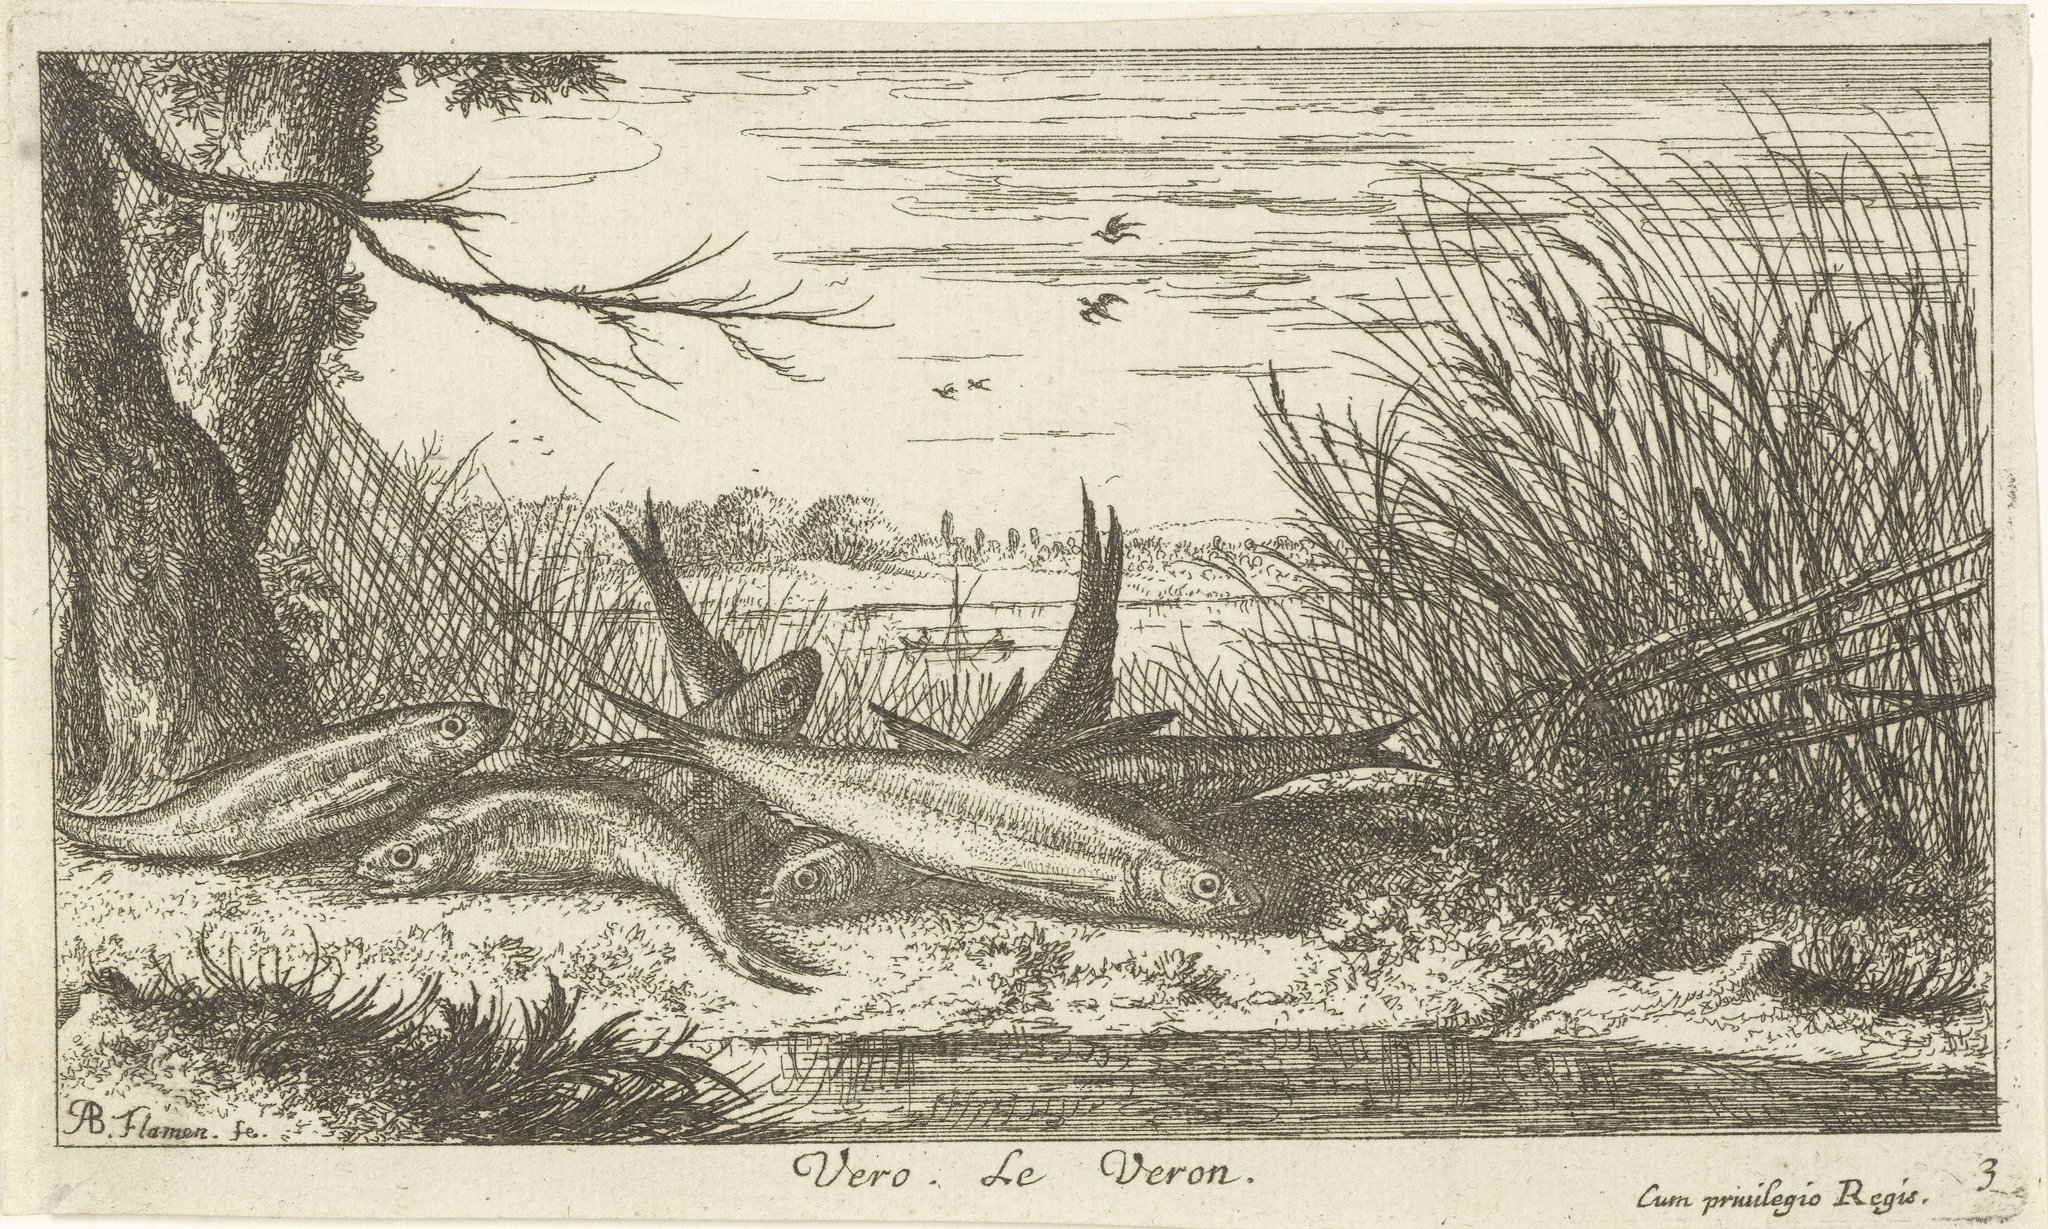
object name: print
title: Seconde partie de Poissons d'eau douce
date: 1664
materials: paper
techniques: etching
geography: paris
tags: fishes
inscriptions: collector's mark: Lugt 2228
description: Zes vissen op de oever van een rivier, tussen riet, bomen en een visnet.